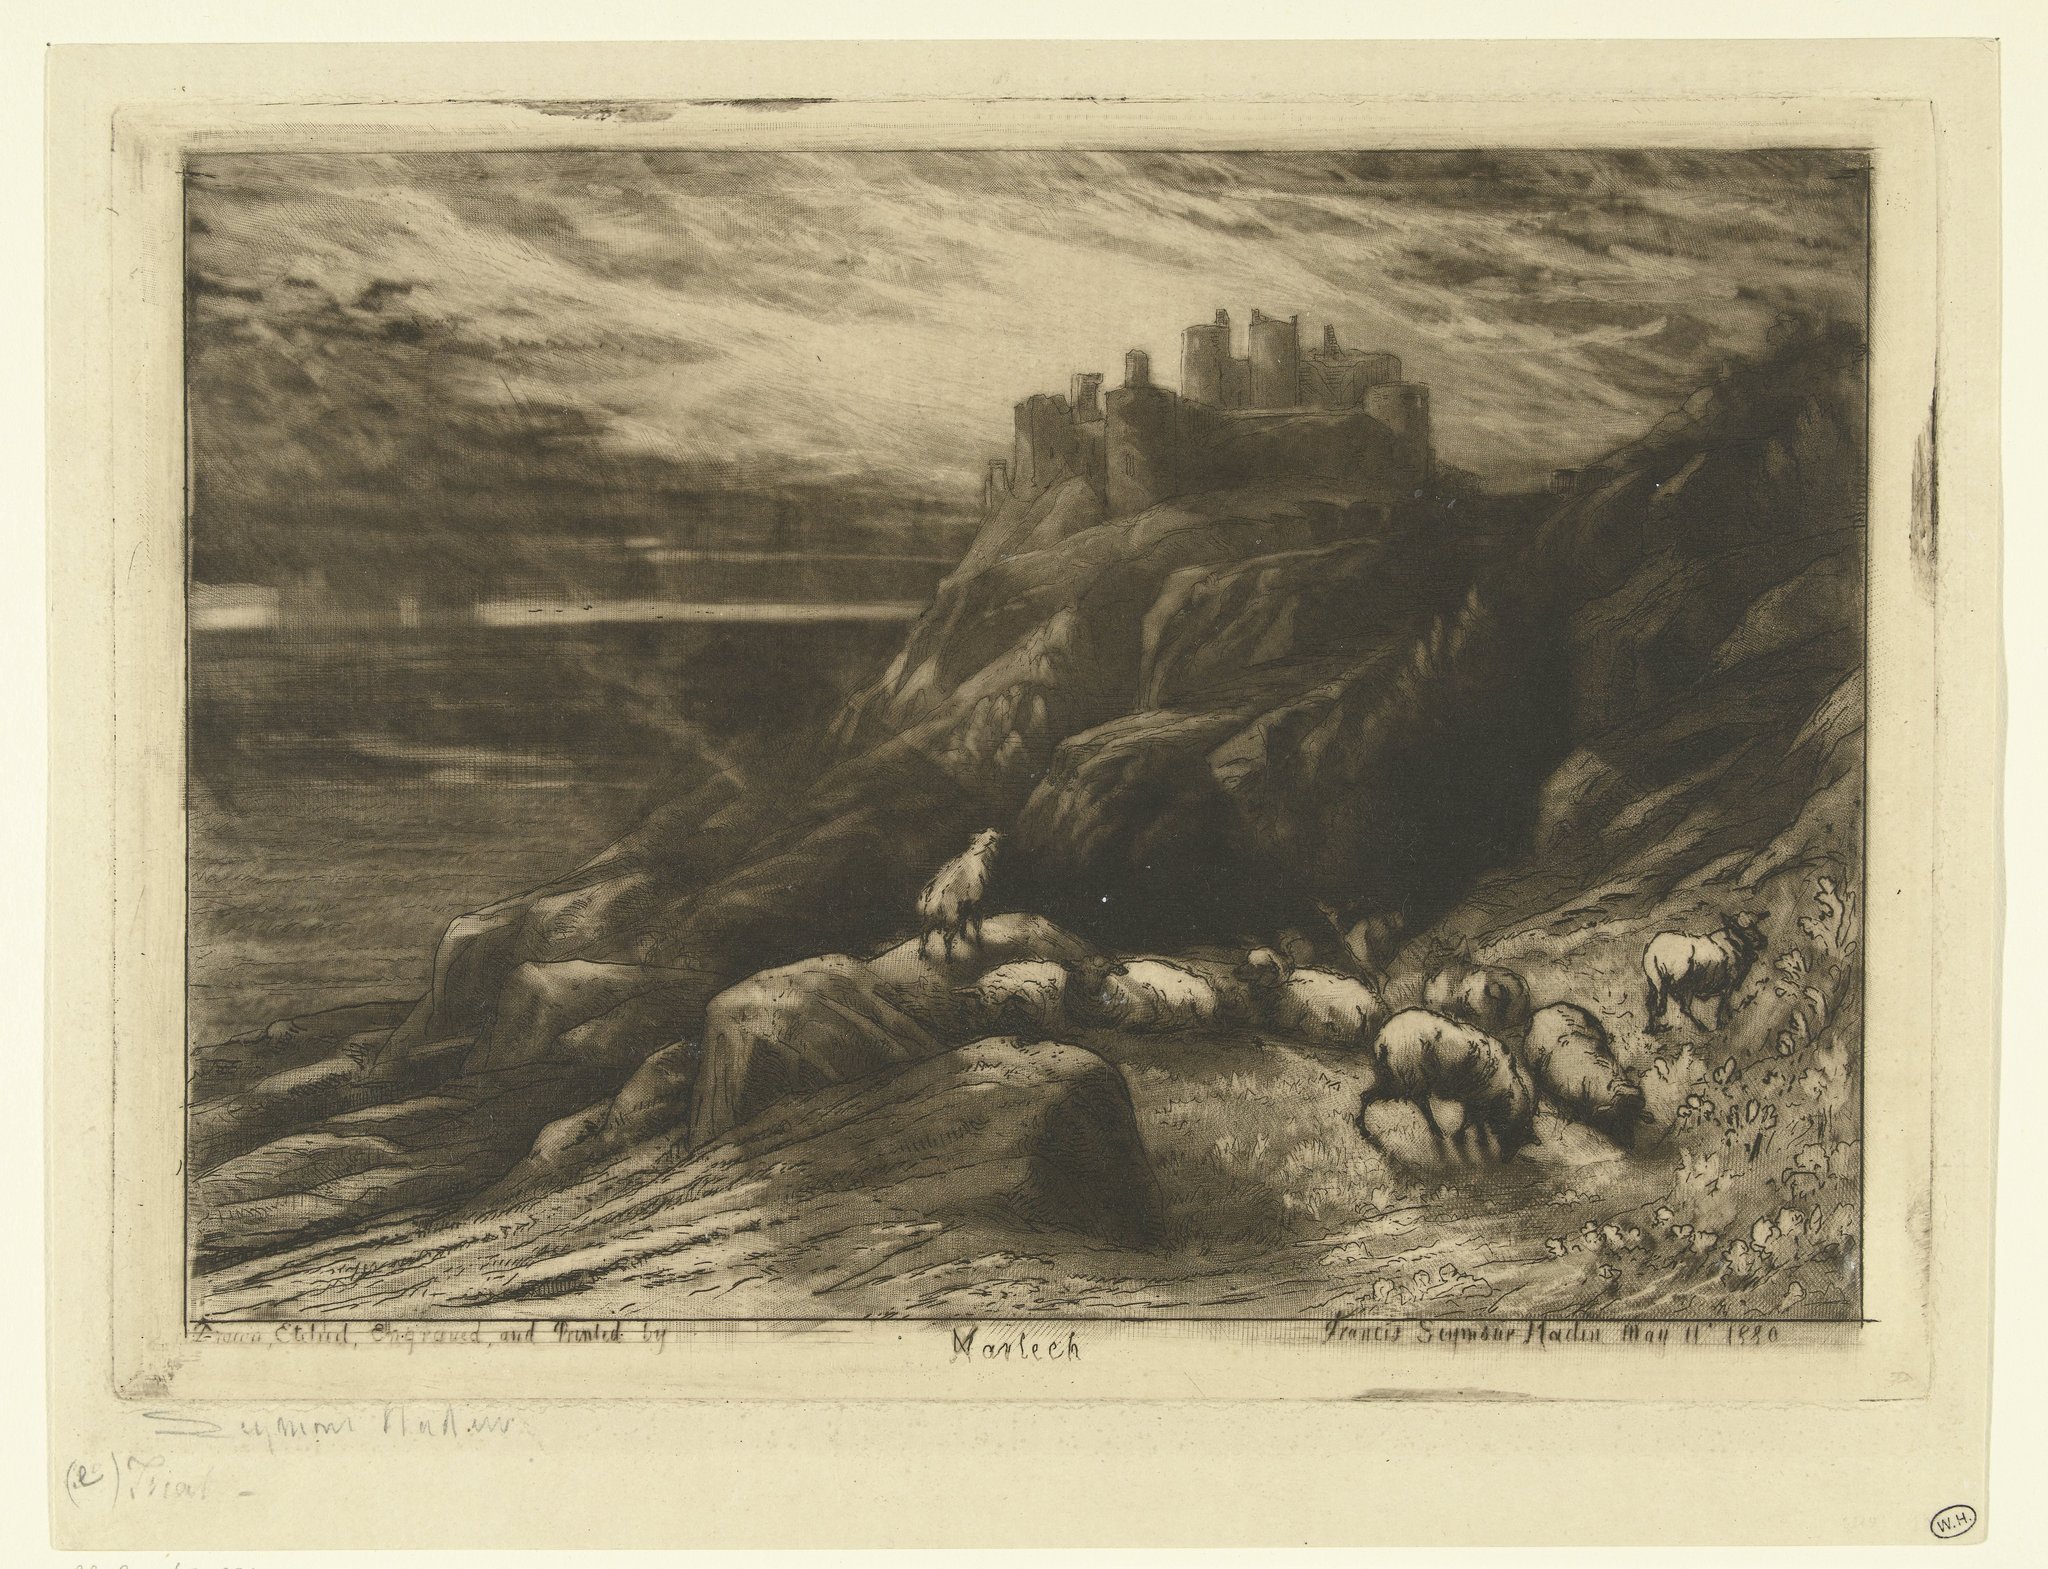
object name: print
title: Harlech Castle in Wales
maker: francis seymour-haden (sir)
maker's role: print maker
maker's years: 1818-1910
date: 1880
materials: paper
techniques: drypoint, etching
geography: england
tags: landscape with tower or castle, sheep, animals (+ herd, group of animals)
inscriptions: inscription: ‘Trail’, collector's mark: Lugt 2760, collector's mark: Lugt 2228, signature: ‘Seymour Haden’, collector's mark: Lugt 3761, collector's mark: Lugt 2625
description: Landschap met een kudde schapen op de voorgrond, op de top van een rots Harlech Castle.